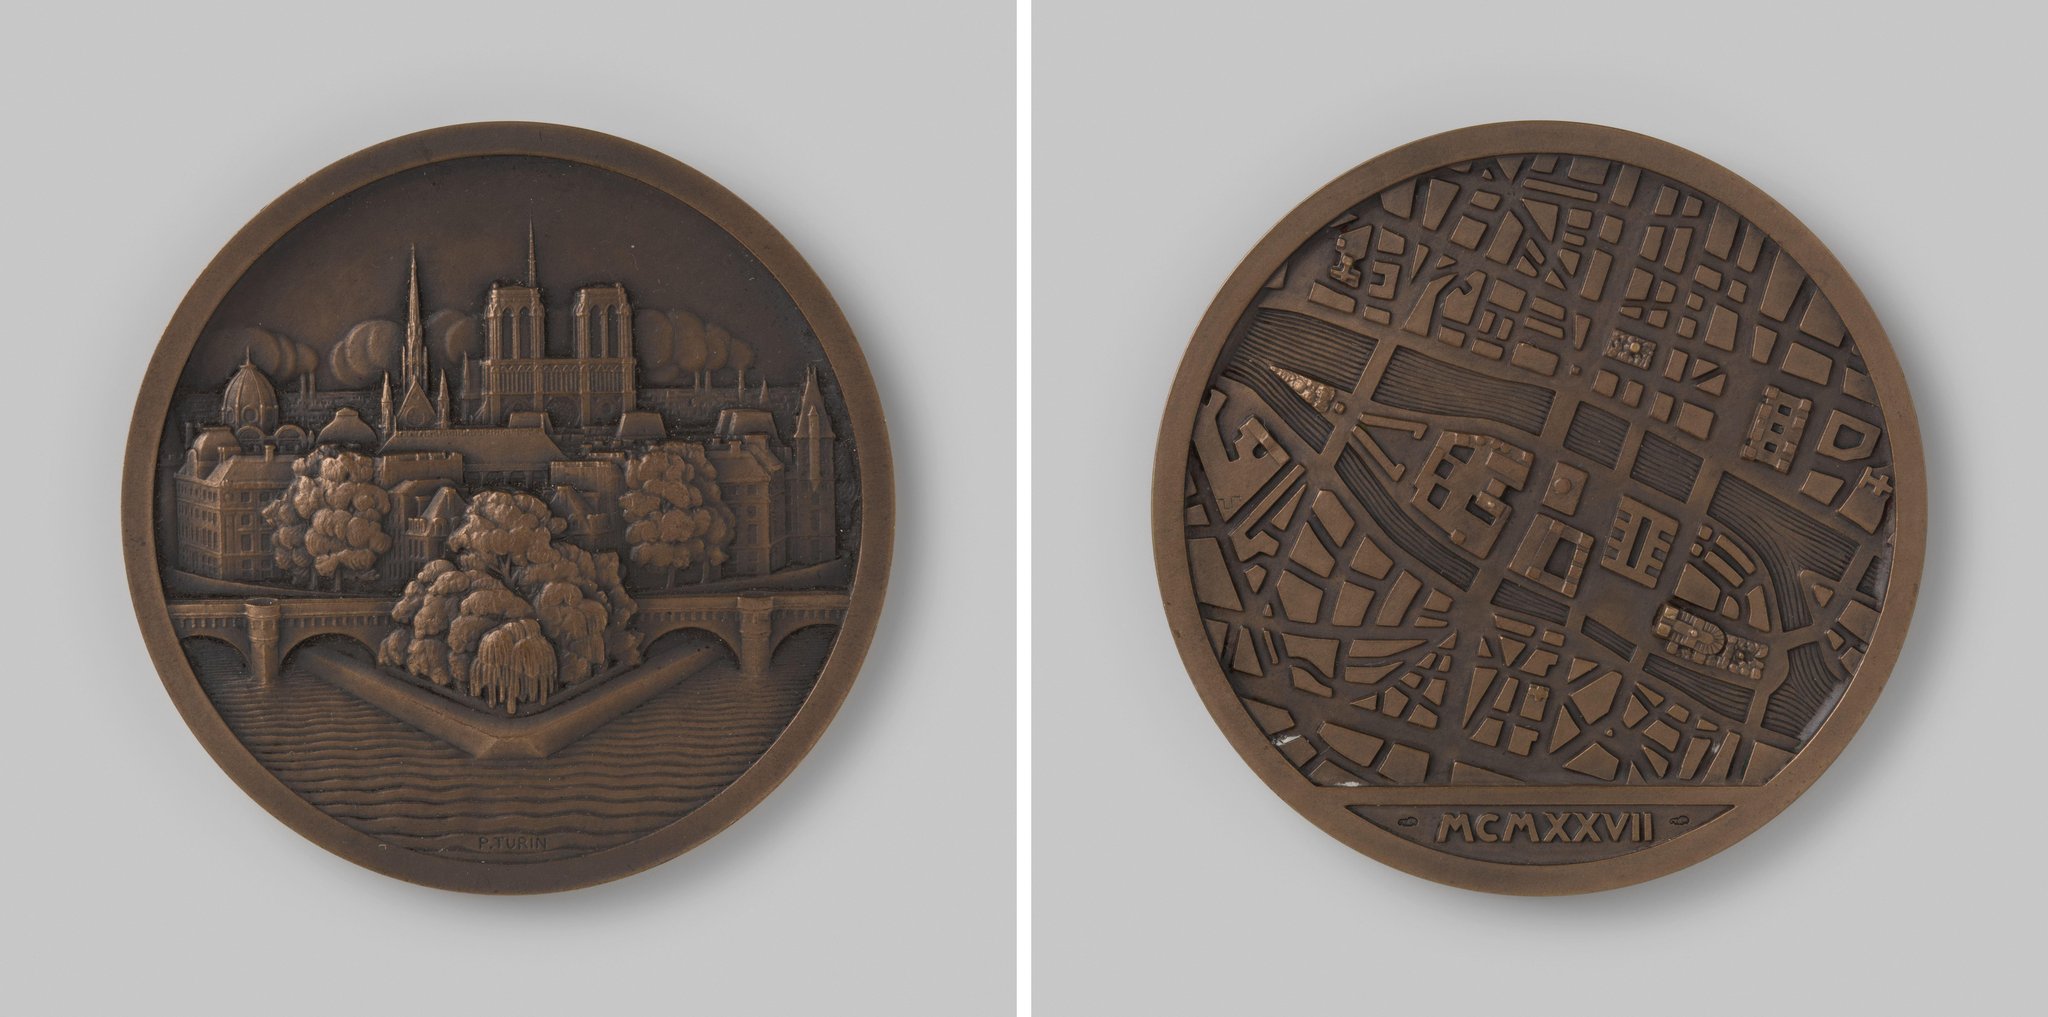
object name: history medal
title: Ile de la Cité in Parijs (1927)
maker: pierre turin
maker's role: medailleur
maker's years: 1891-1968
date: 1927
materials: bronze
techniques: striking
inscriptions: factory mark: ‘(hoorn des overvloeds) MONETA’, number: ‘21’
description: Bronzen penning, op de voorzijde het aanzien van het Ile de la Cité, op de keerzijde de plattegrond van het centrum van Parijs, met afsnedetekst.